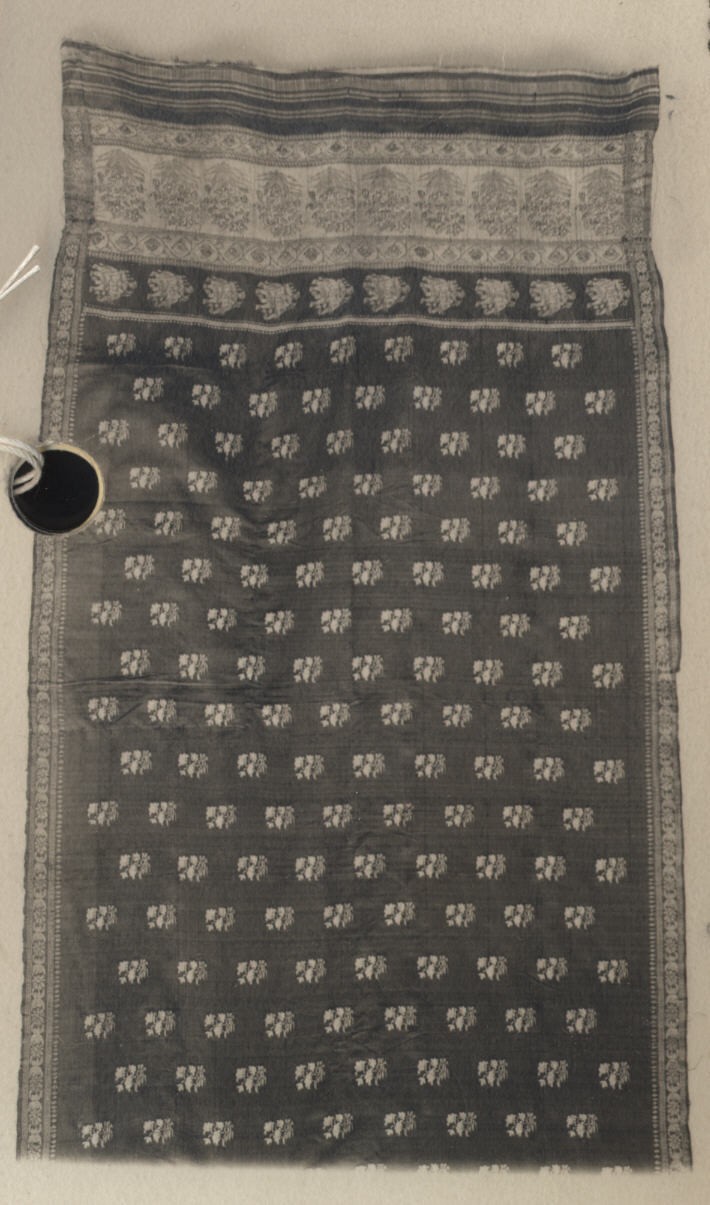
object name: sari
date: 1701-1900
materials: silk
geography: india